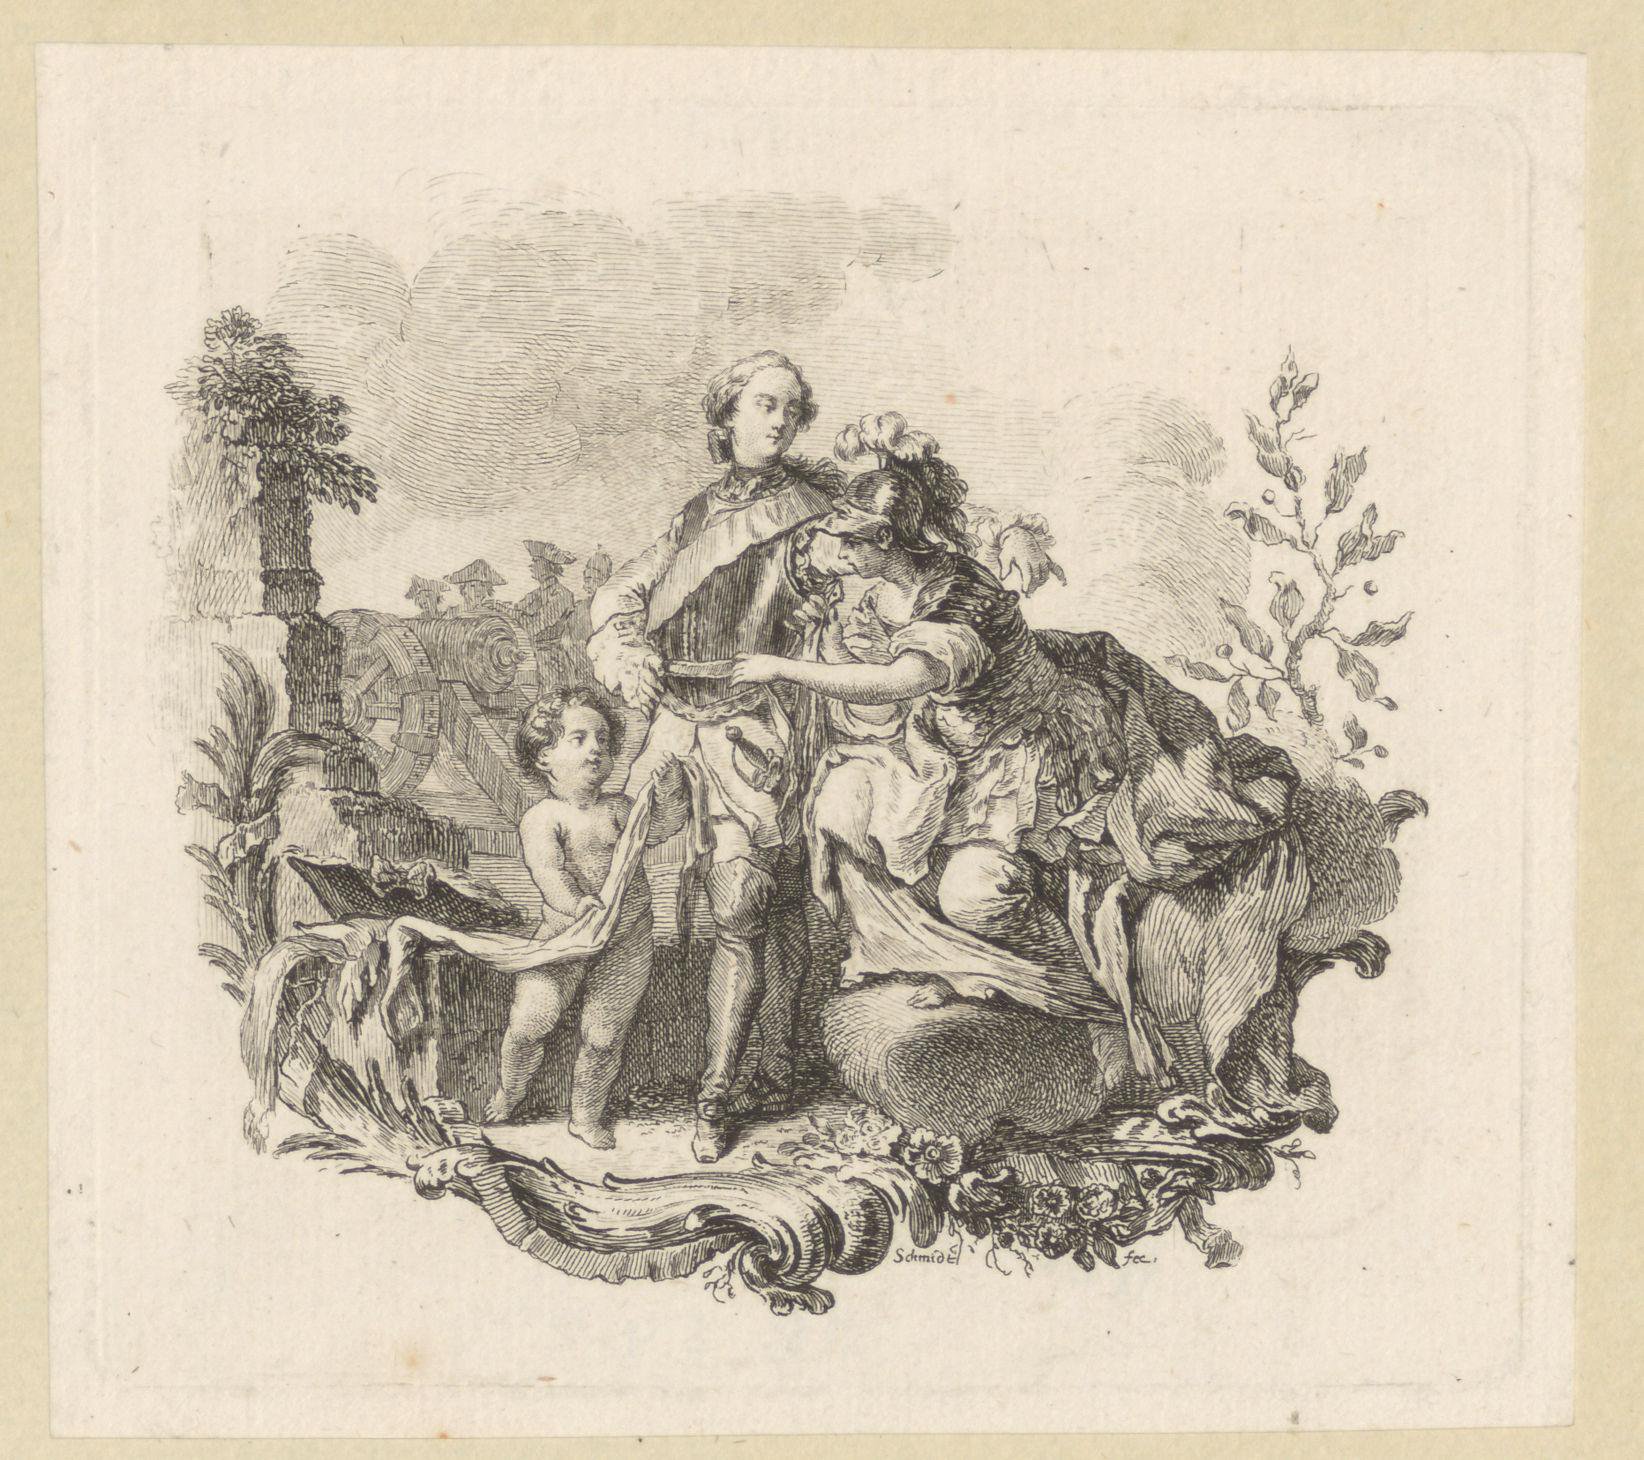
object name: book illustration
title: Held wordt door Bellona de wapens aangegeven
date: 1760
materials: paper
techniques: etching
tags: men of name and fame, heroes, 'homines illustres', 'uomini famosi', bellona (enyo)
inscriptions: collector's mark: Lugt 240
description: Prent ook gebruikt in: Frederik de Grote. Poësies diverses. Sanssouci, Frederik de Grote, 1760.